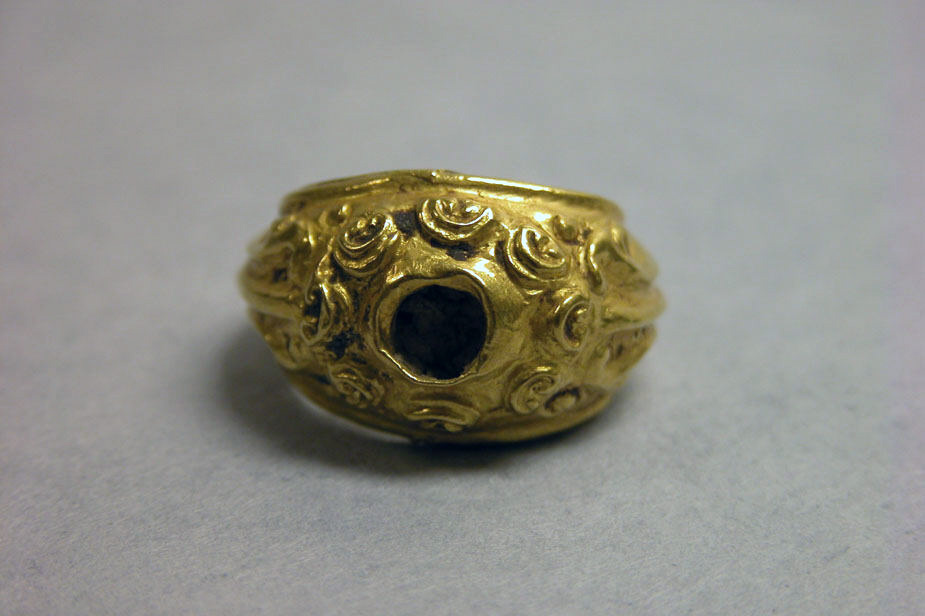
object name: ring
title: Stirrup-shaped Ring with Oval Bezel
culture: indonesian, javanese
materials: gold